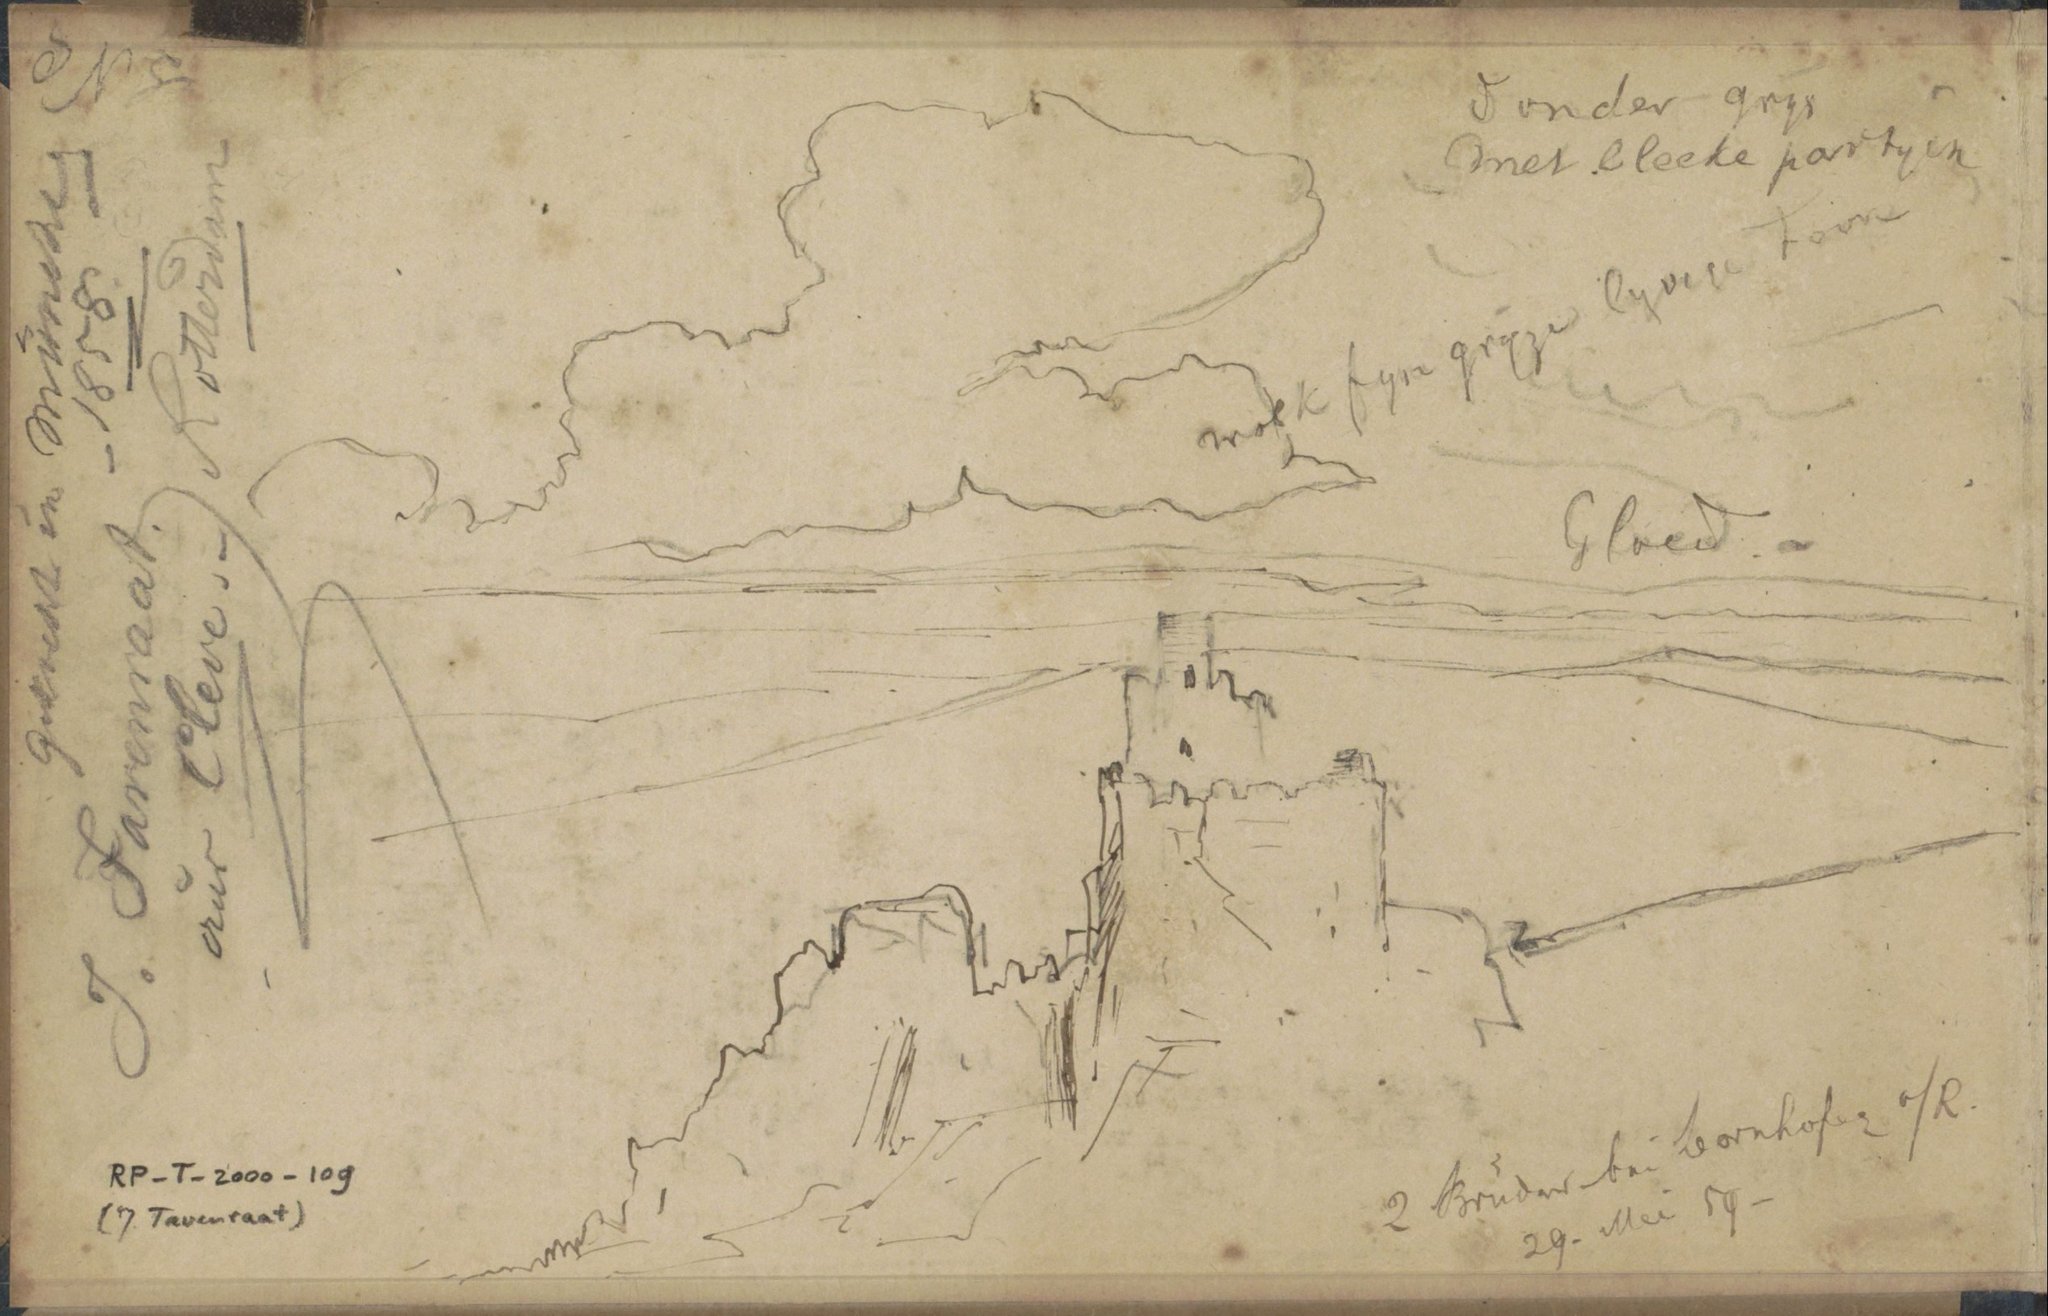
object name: sketchbook leaf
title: Landschap met een kasteelruïne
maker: johannes tavenraat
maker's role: draughtsman, painter, print maker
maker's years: 1809-1881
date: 1805-1859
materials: ink, paper, pencil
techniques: pen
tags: city-view, and landscape with man-made constructions, ruin of a dwelling, house, castle, etc.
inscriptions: date and inscription: ‘gekocht in München / 1858 / J. Tavenraat / zür Cleve - Rotterdam/ 2 Brüder bei Dornhofer a/R/ 29. Mei 59-’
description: Voorste schutblad uit een schetsboek met 48 bladen.